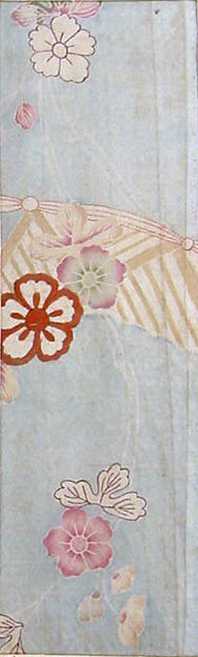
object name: piece from a kosode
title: Pieces from a Kosode with Flowers, Vines, and Garden Fence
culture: japanese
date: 1615-1868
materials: metal thread, silk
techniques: dyeing, embroidery, painting, weave, resist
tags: flowers